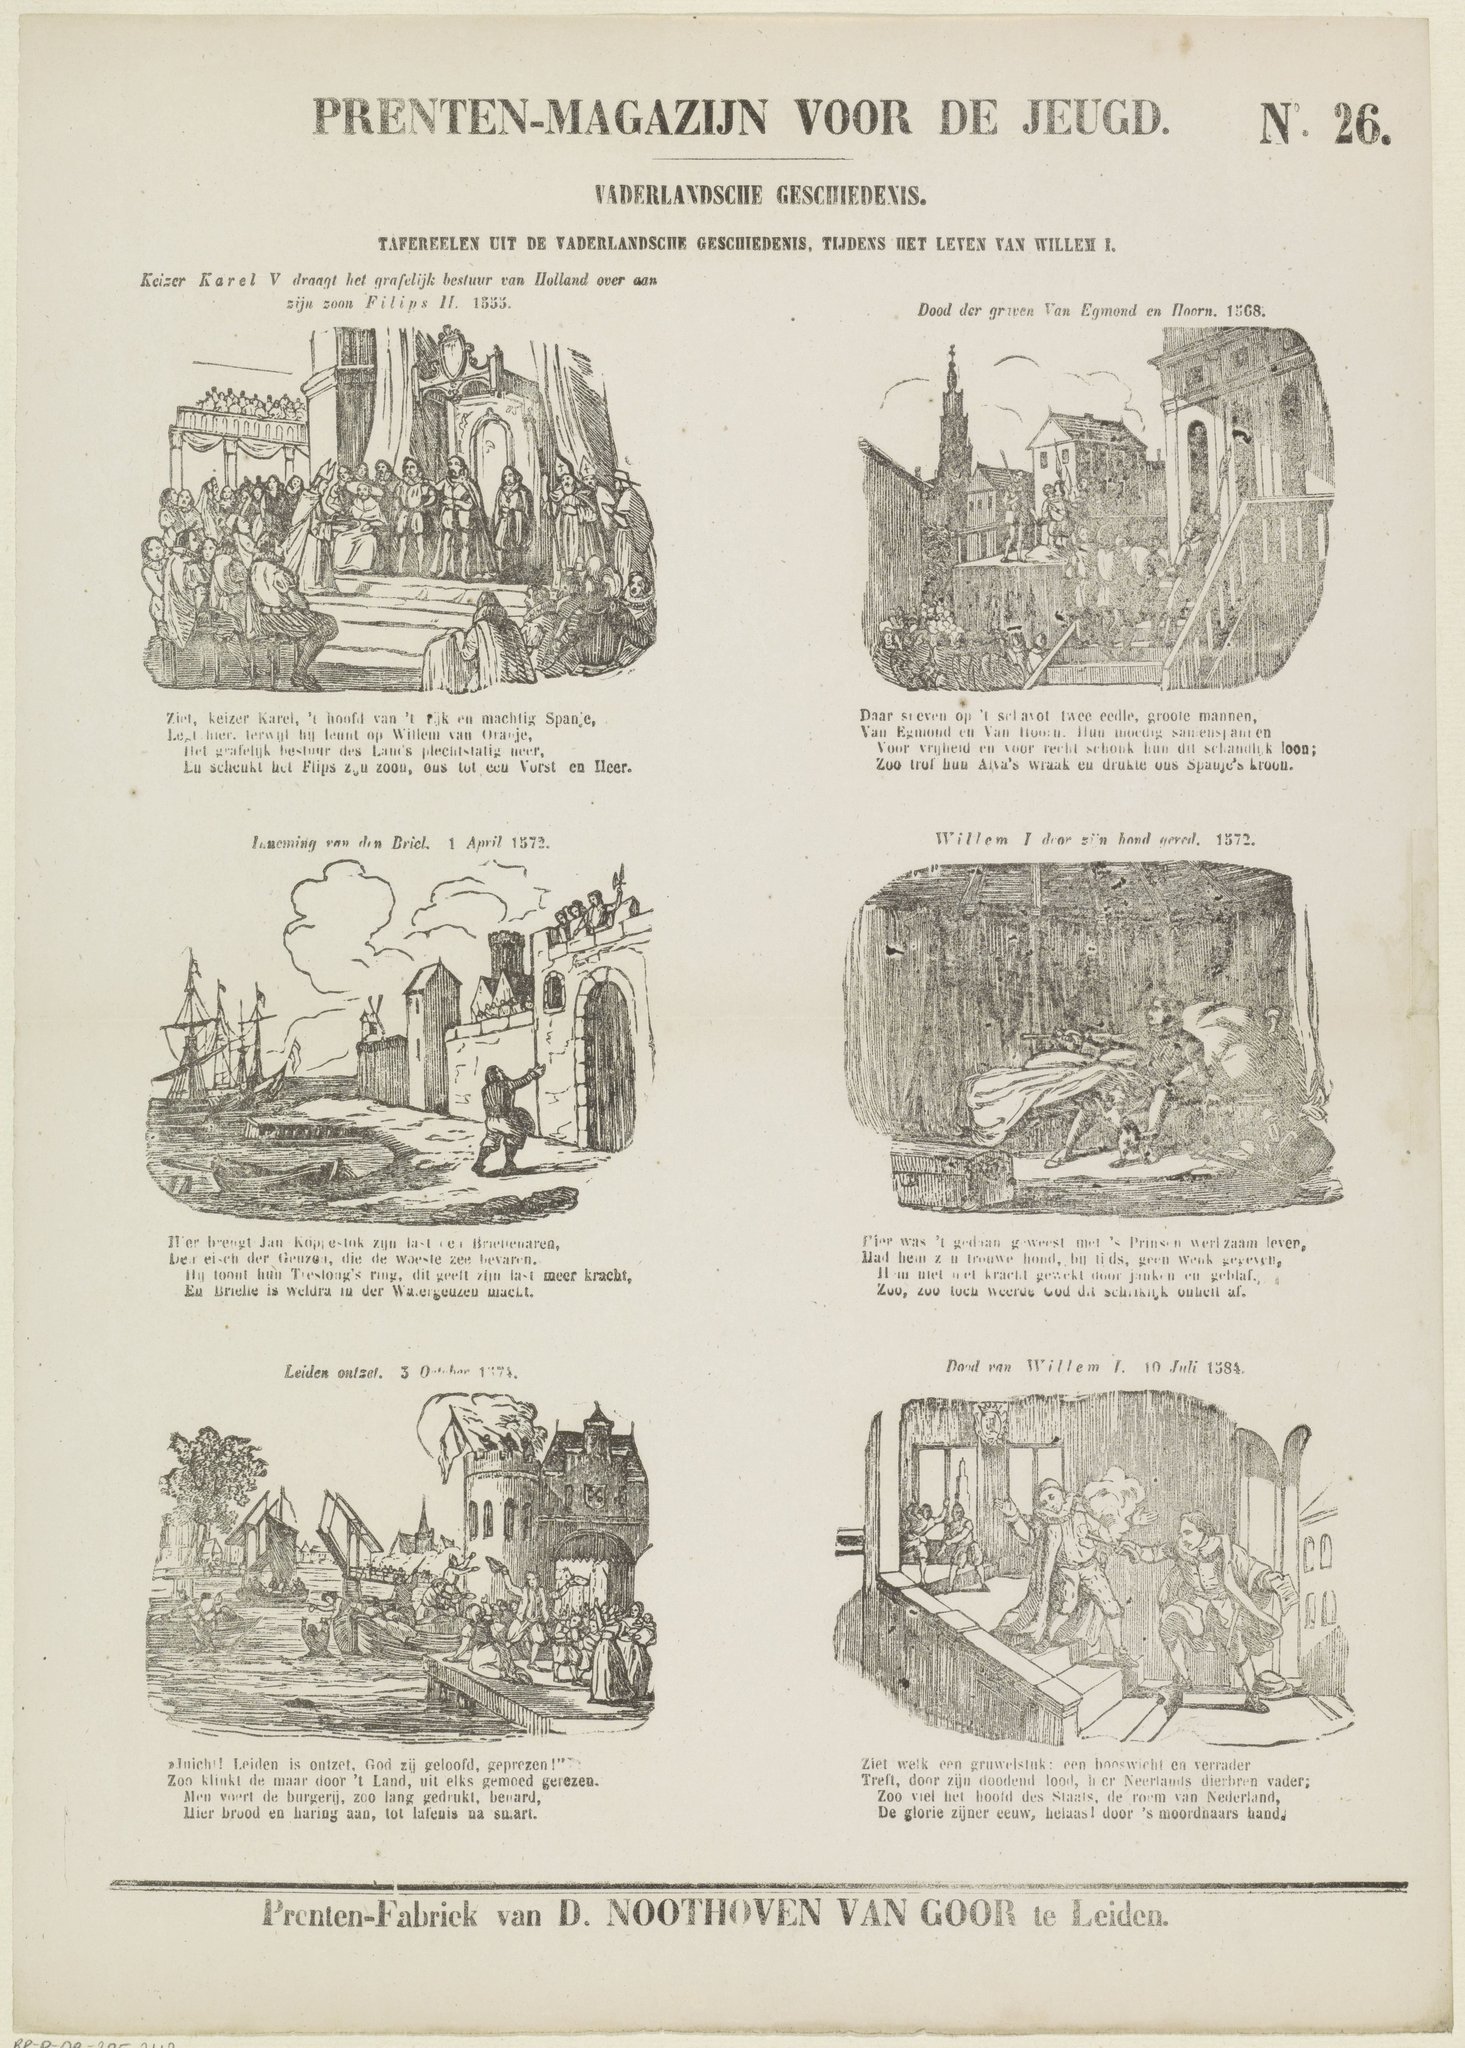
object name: print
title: Vaderlandsche geschiedenis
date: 1850-1881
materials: paper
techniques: letterpress printing, engraving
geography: leiden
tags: philip ii of spain, delft, william i (prince of orange), ghent, charles v (holy roman emperor and king of spain), brussels, earl, history, murder, murderer, leiden, brielle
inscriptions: collector's mark: Lugt 2760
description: Blad met 6 voorstellingen van gebeurtenissen uit de vaderlandse geschiedenis, ten tijde van Willem I. Boven elke voorstelling een titel en onder elke voorstelling een vierregelig vers. Genummerd rechtsboven: No. 26.